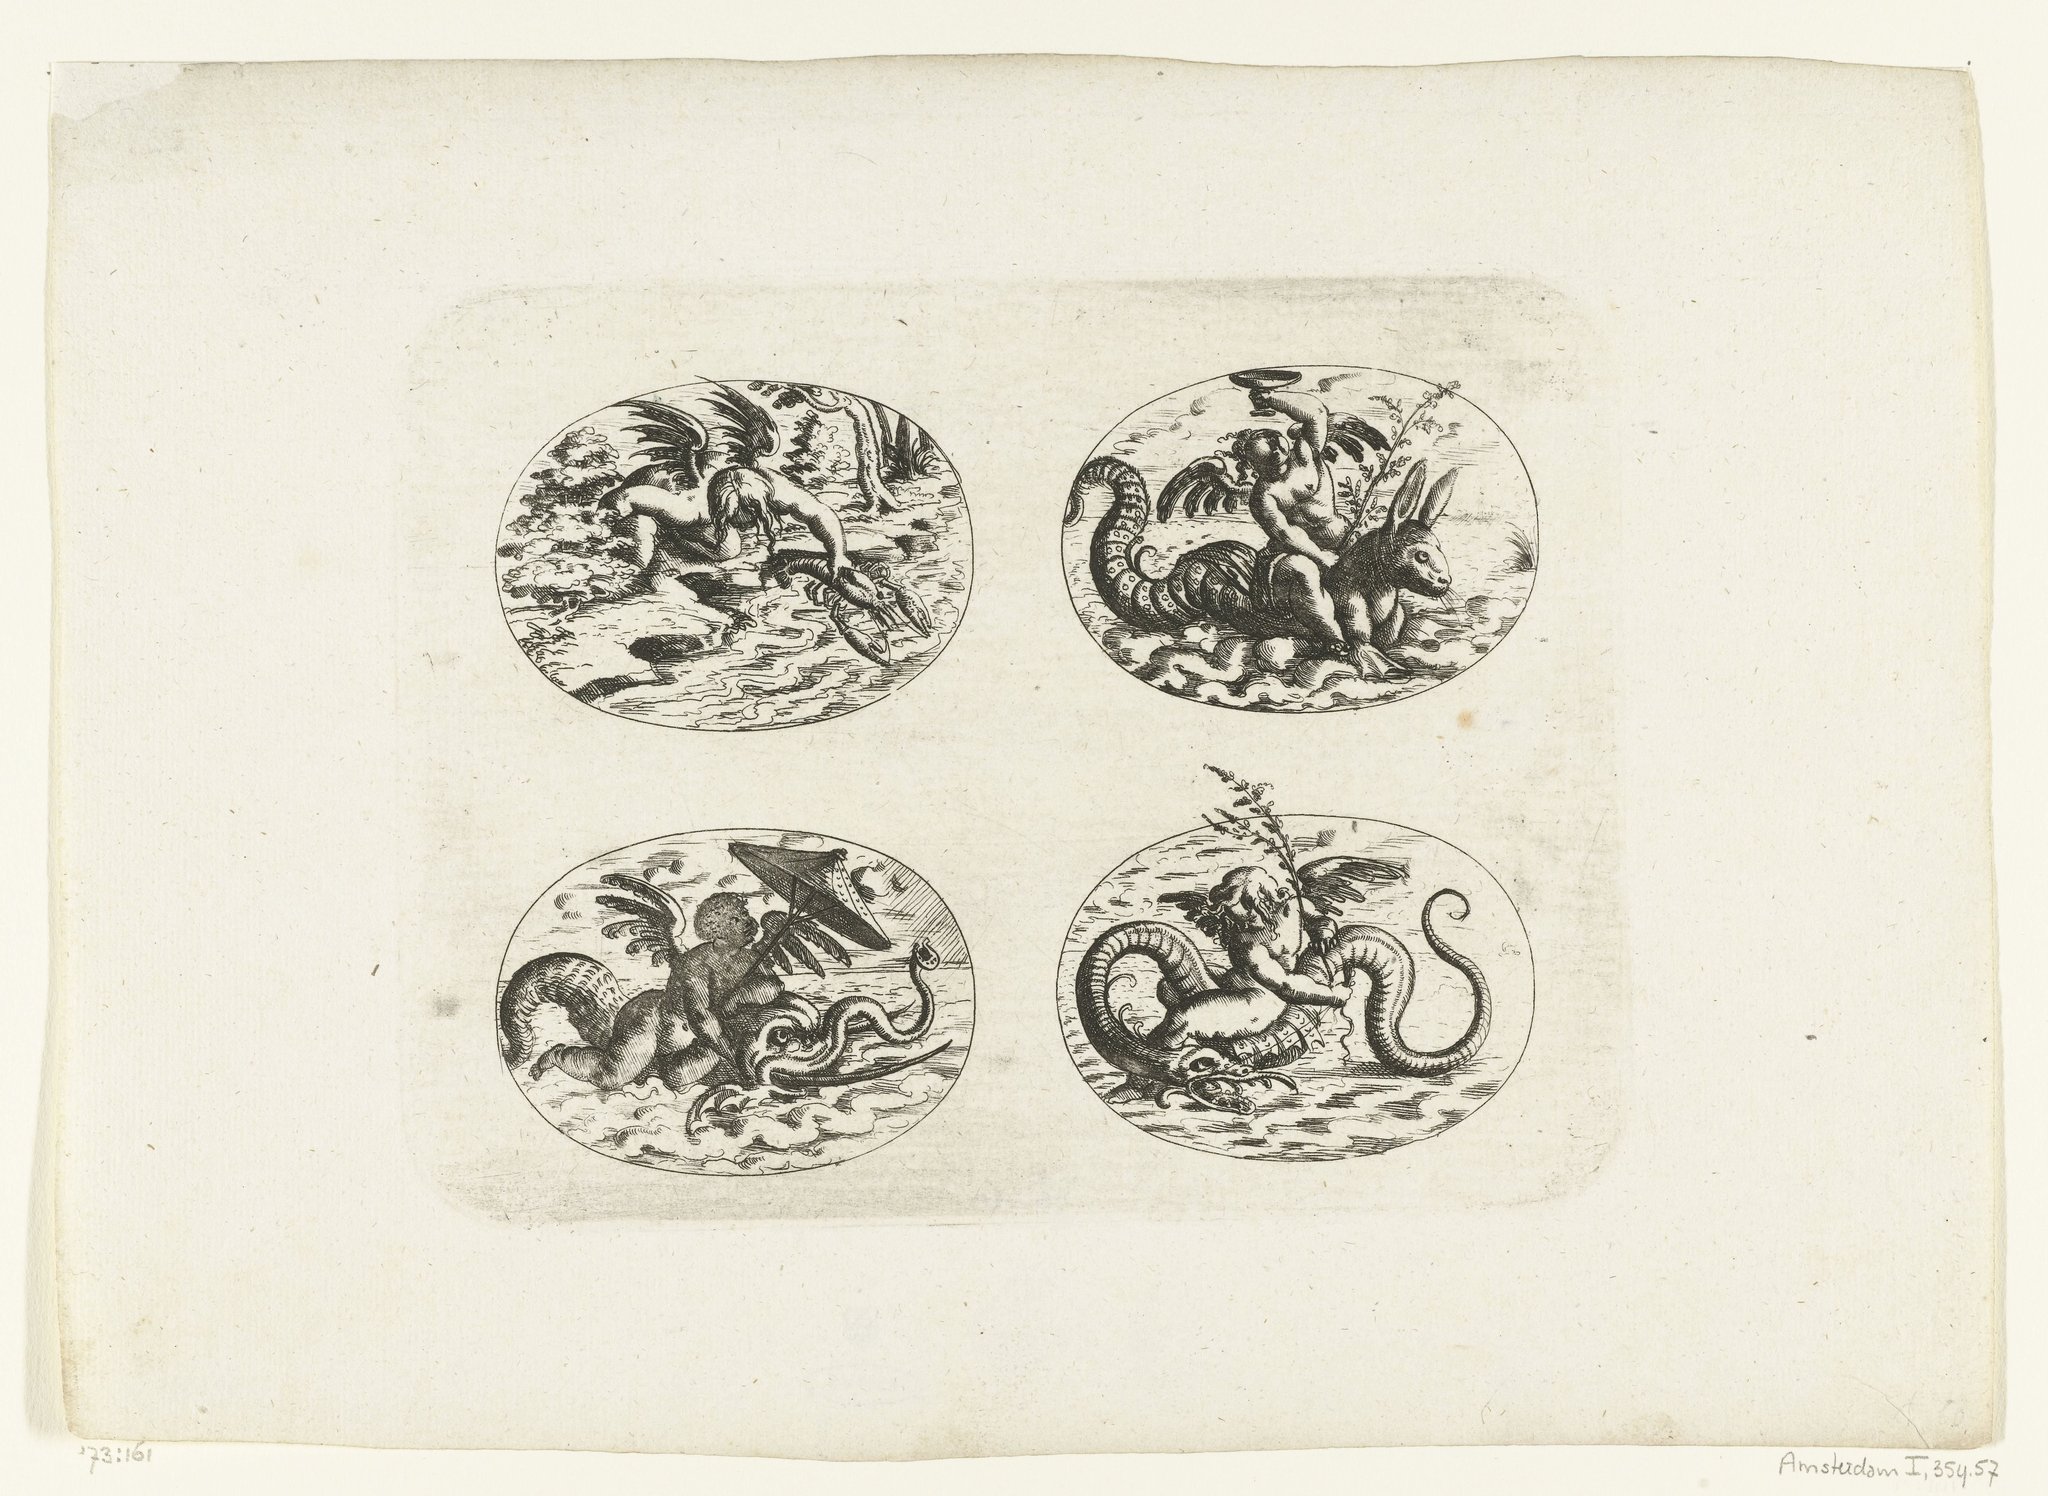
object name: print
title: Vier liggende ovalen met putti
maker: christoph jamnitzer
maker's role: draughtsman, goldsmith, print maker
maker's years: 1563-1618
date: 1573-1610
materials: paper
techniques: etching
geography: germany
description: Linksboven een putto die op zijn knieën vooroverliggend een kreeft uit het water haalt, rechtsboven een putto met een schaal in de hand, rijdend op een zeehaas, linksonder een putto met een parapluie, rijdend op een vis met slagtanden, en rechtsonder een putto met een tak in de arm, rijdend op een zeeslang. Blad uit een serie vlakdecoraties met grotesken, cartouches, ovalen, mascarons, putti en fantastische wezens. De serie bestaat uit drie titelbladen, twee tekstbladen met de opdracht en het voorwoord en 60 bladen, verdeeld over drie boeken.